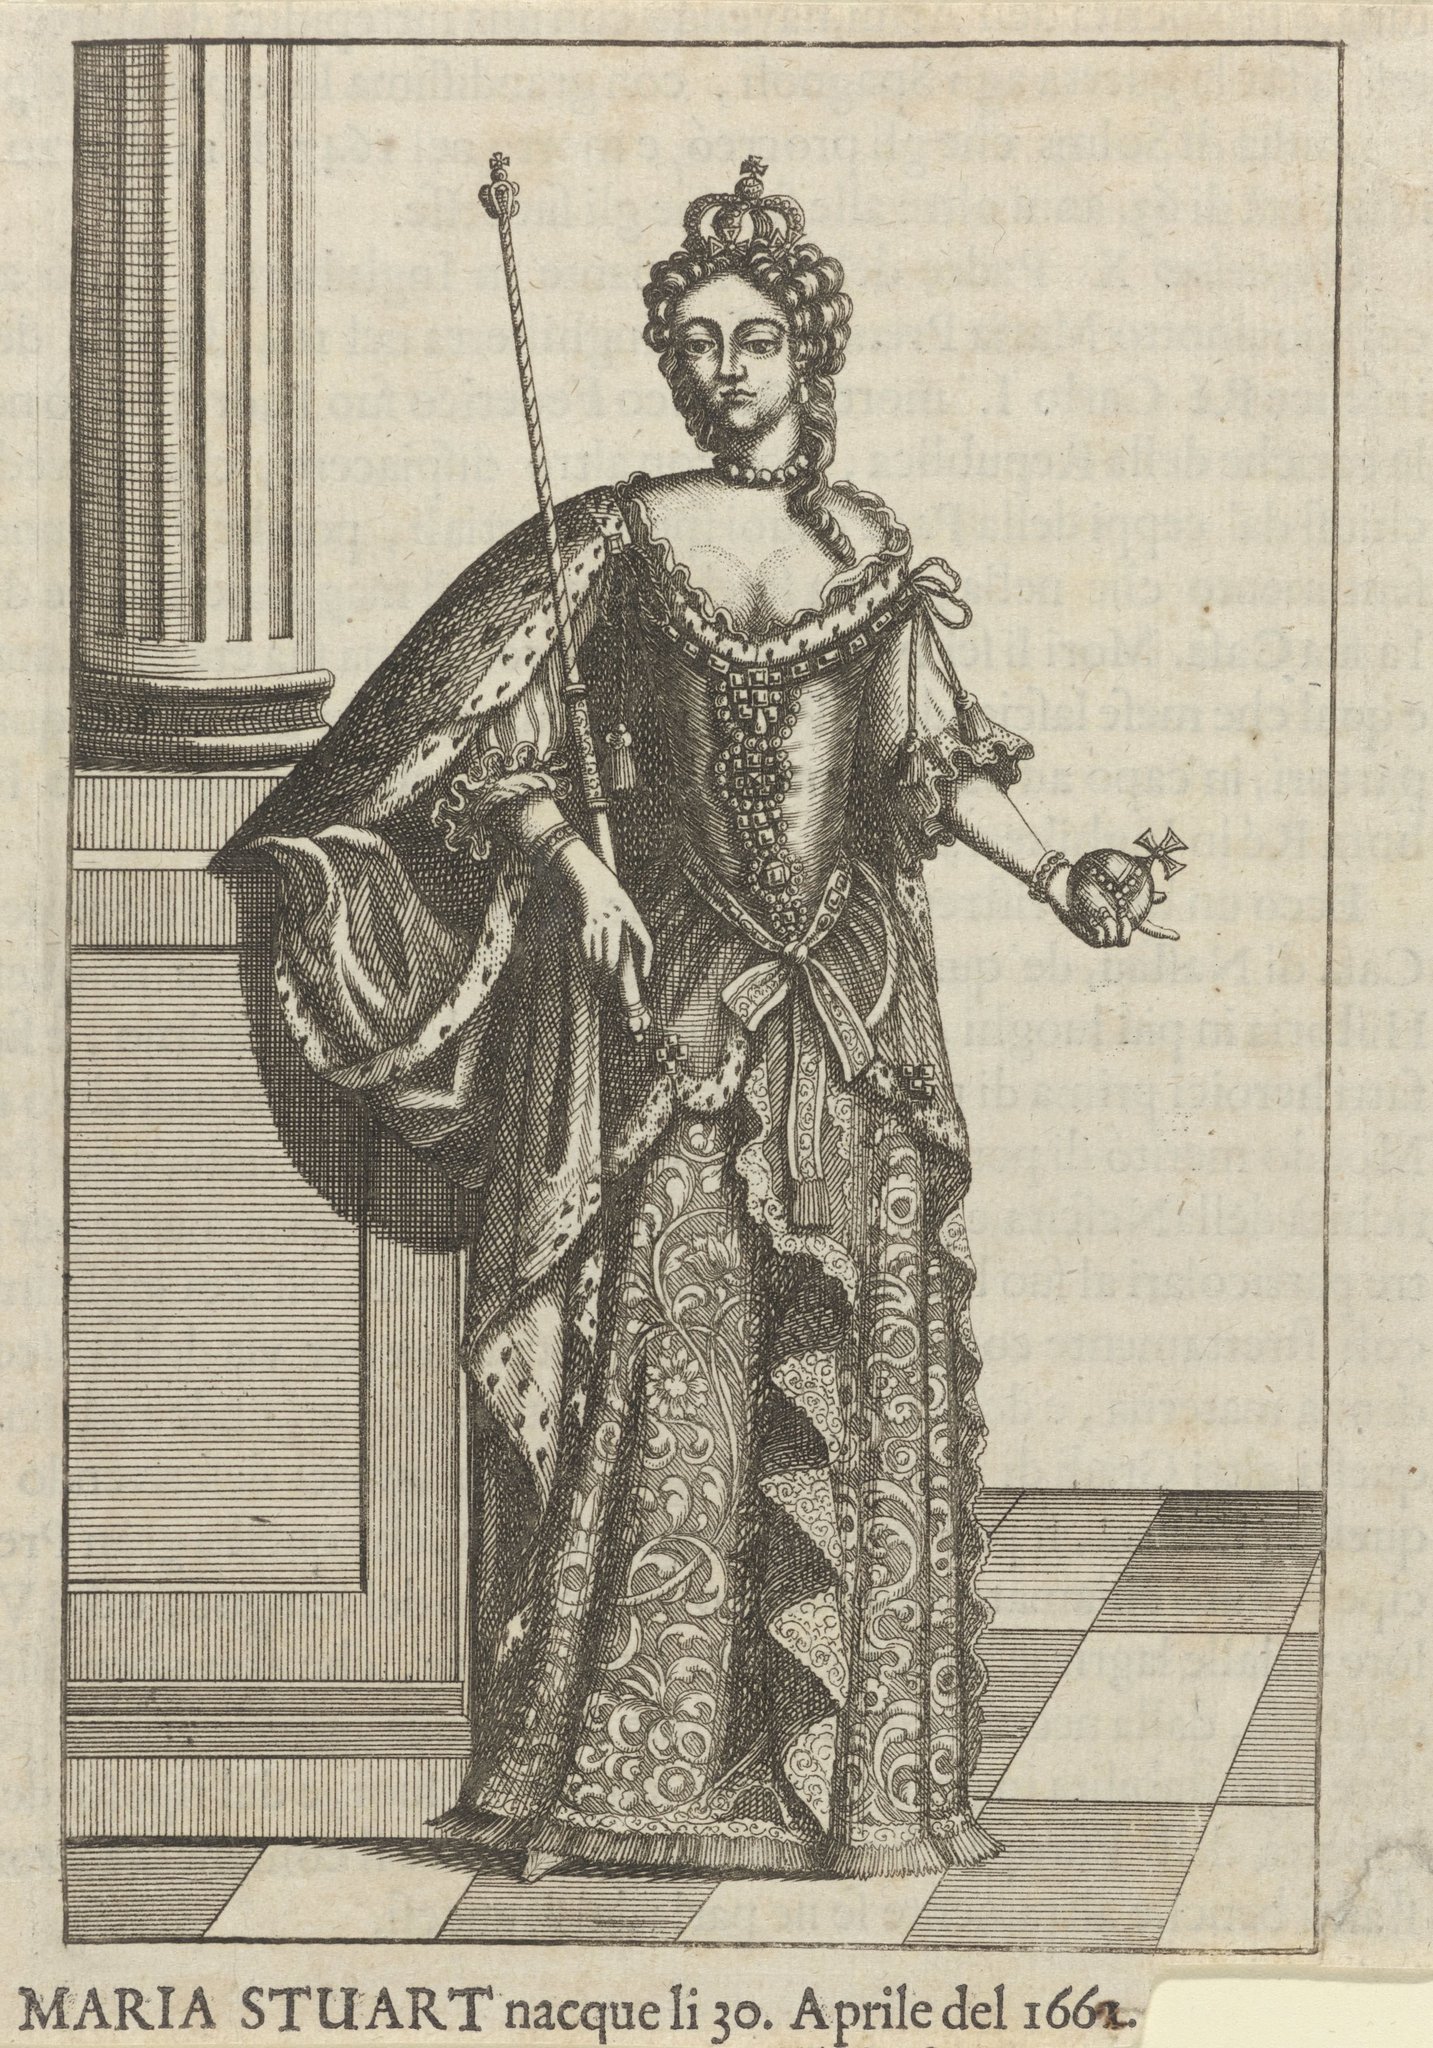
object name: print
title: Portret van Maria II Stuart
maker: Anonymous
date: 1688-1749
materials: paper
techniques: engraving, etching, letterpress printing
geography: low countries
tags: london, maria ii stuart (koningin van engeland, schotland en ierland)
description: Portret van Maria II met een kroon. In haar rechterhand een scepter en in haar linkerhand de rijksappel.